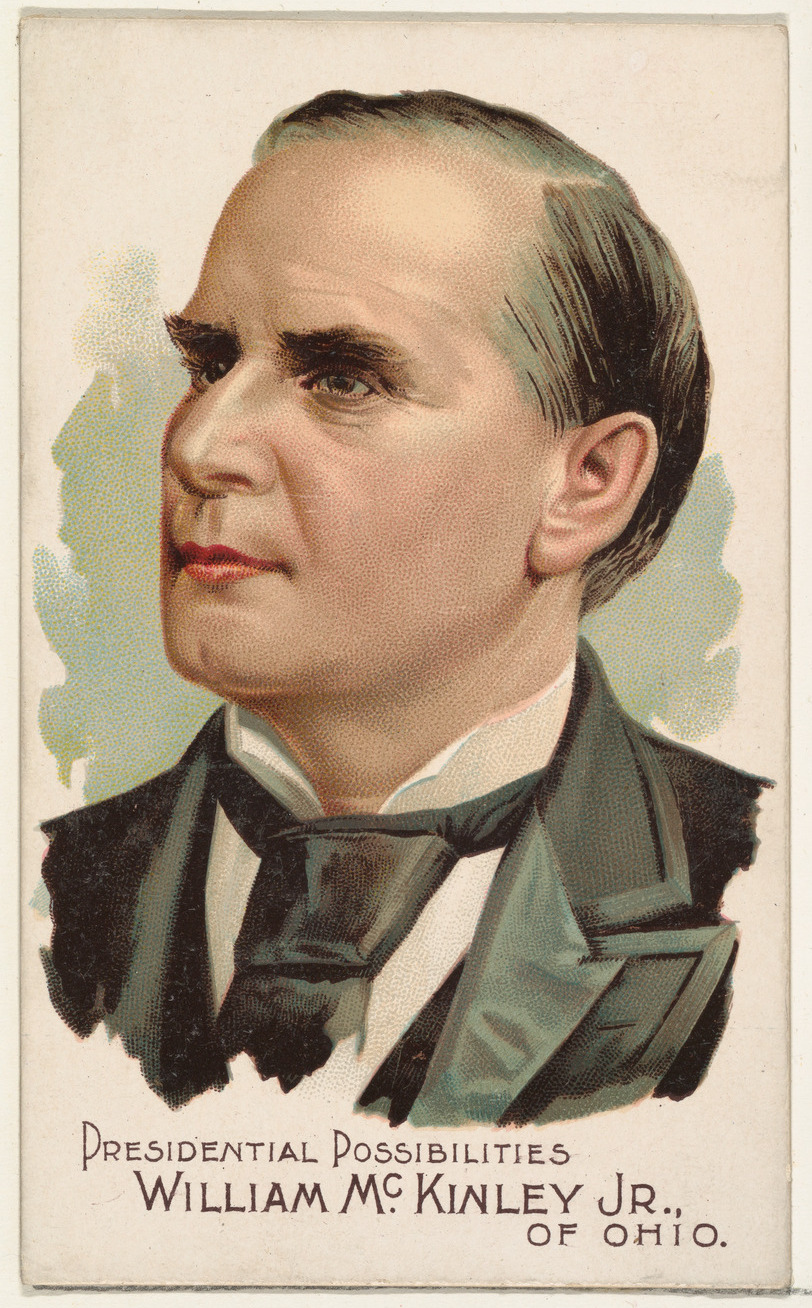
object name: print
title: William McKinley Jr. of Ohio, from the Presidential Possibilities series (N124) issued by Duke Sons & Co. to promote Honest Long Cut Tobacco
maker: w. duke, sons & co.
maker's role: publisher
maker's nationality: american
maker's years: 1870-1920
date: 1888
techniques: color lithograph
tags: men,portraits